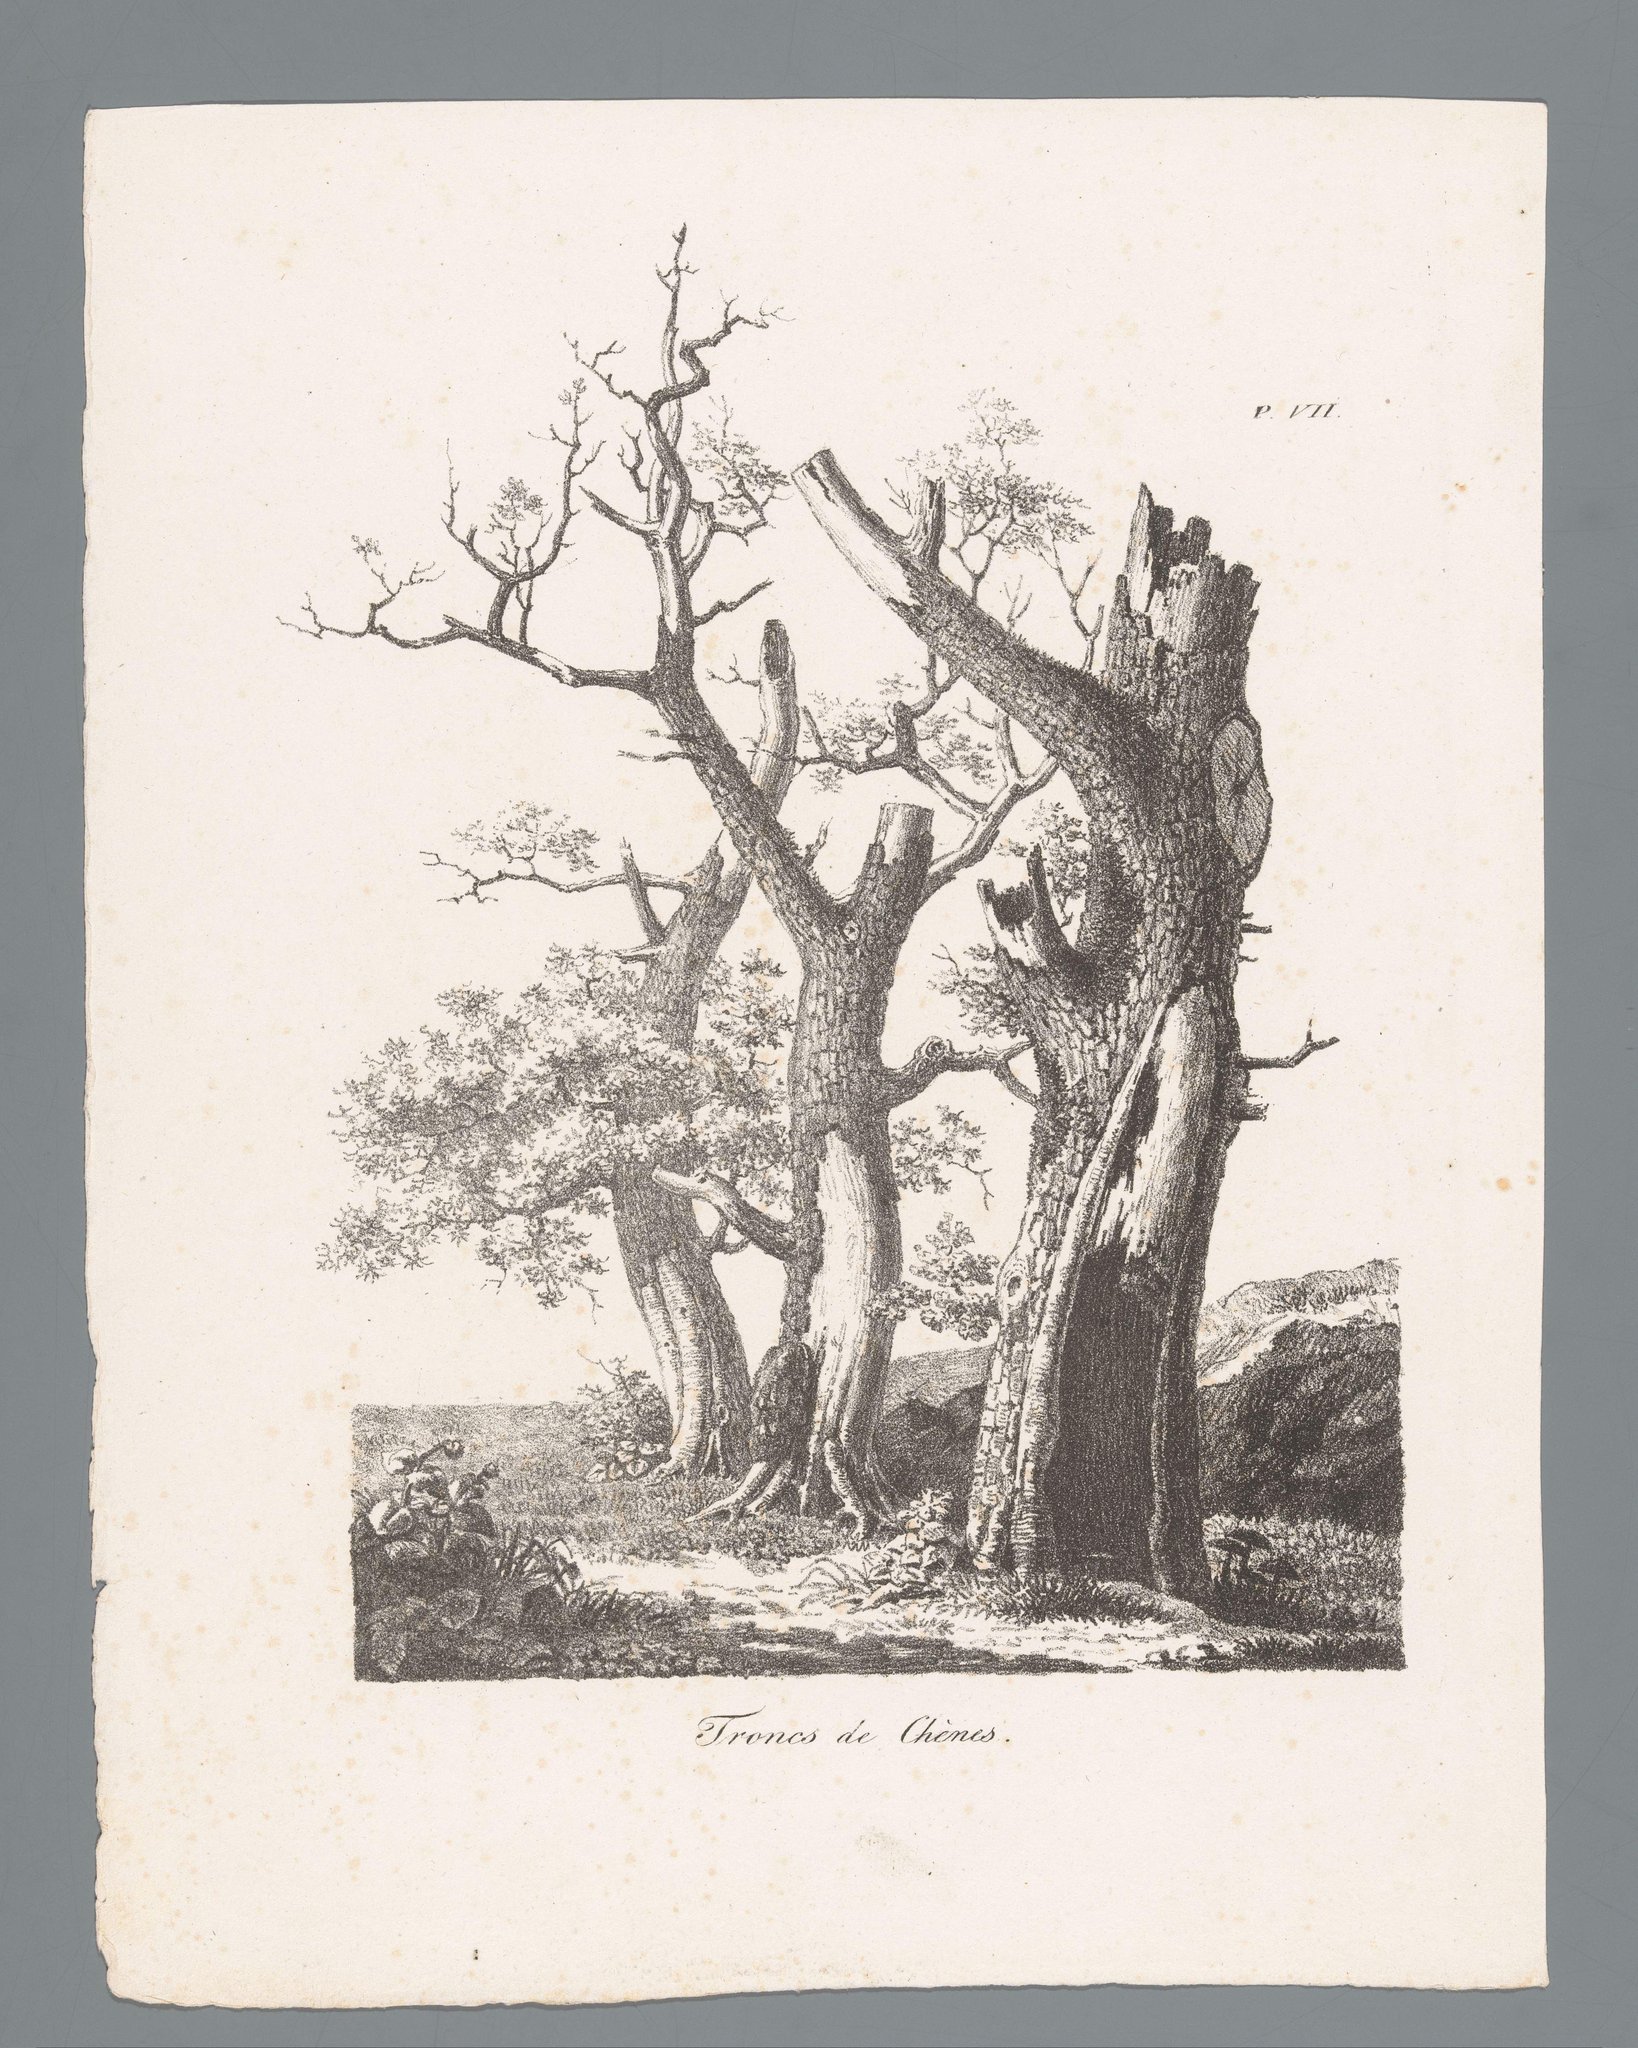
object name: print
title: Trones de Chènes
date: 1820-1833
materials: paper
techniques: lithograph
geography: mulhouse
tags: trees: oak (+ stem, trunk)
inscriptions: collector's mark: Lugt 2228